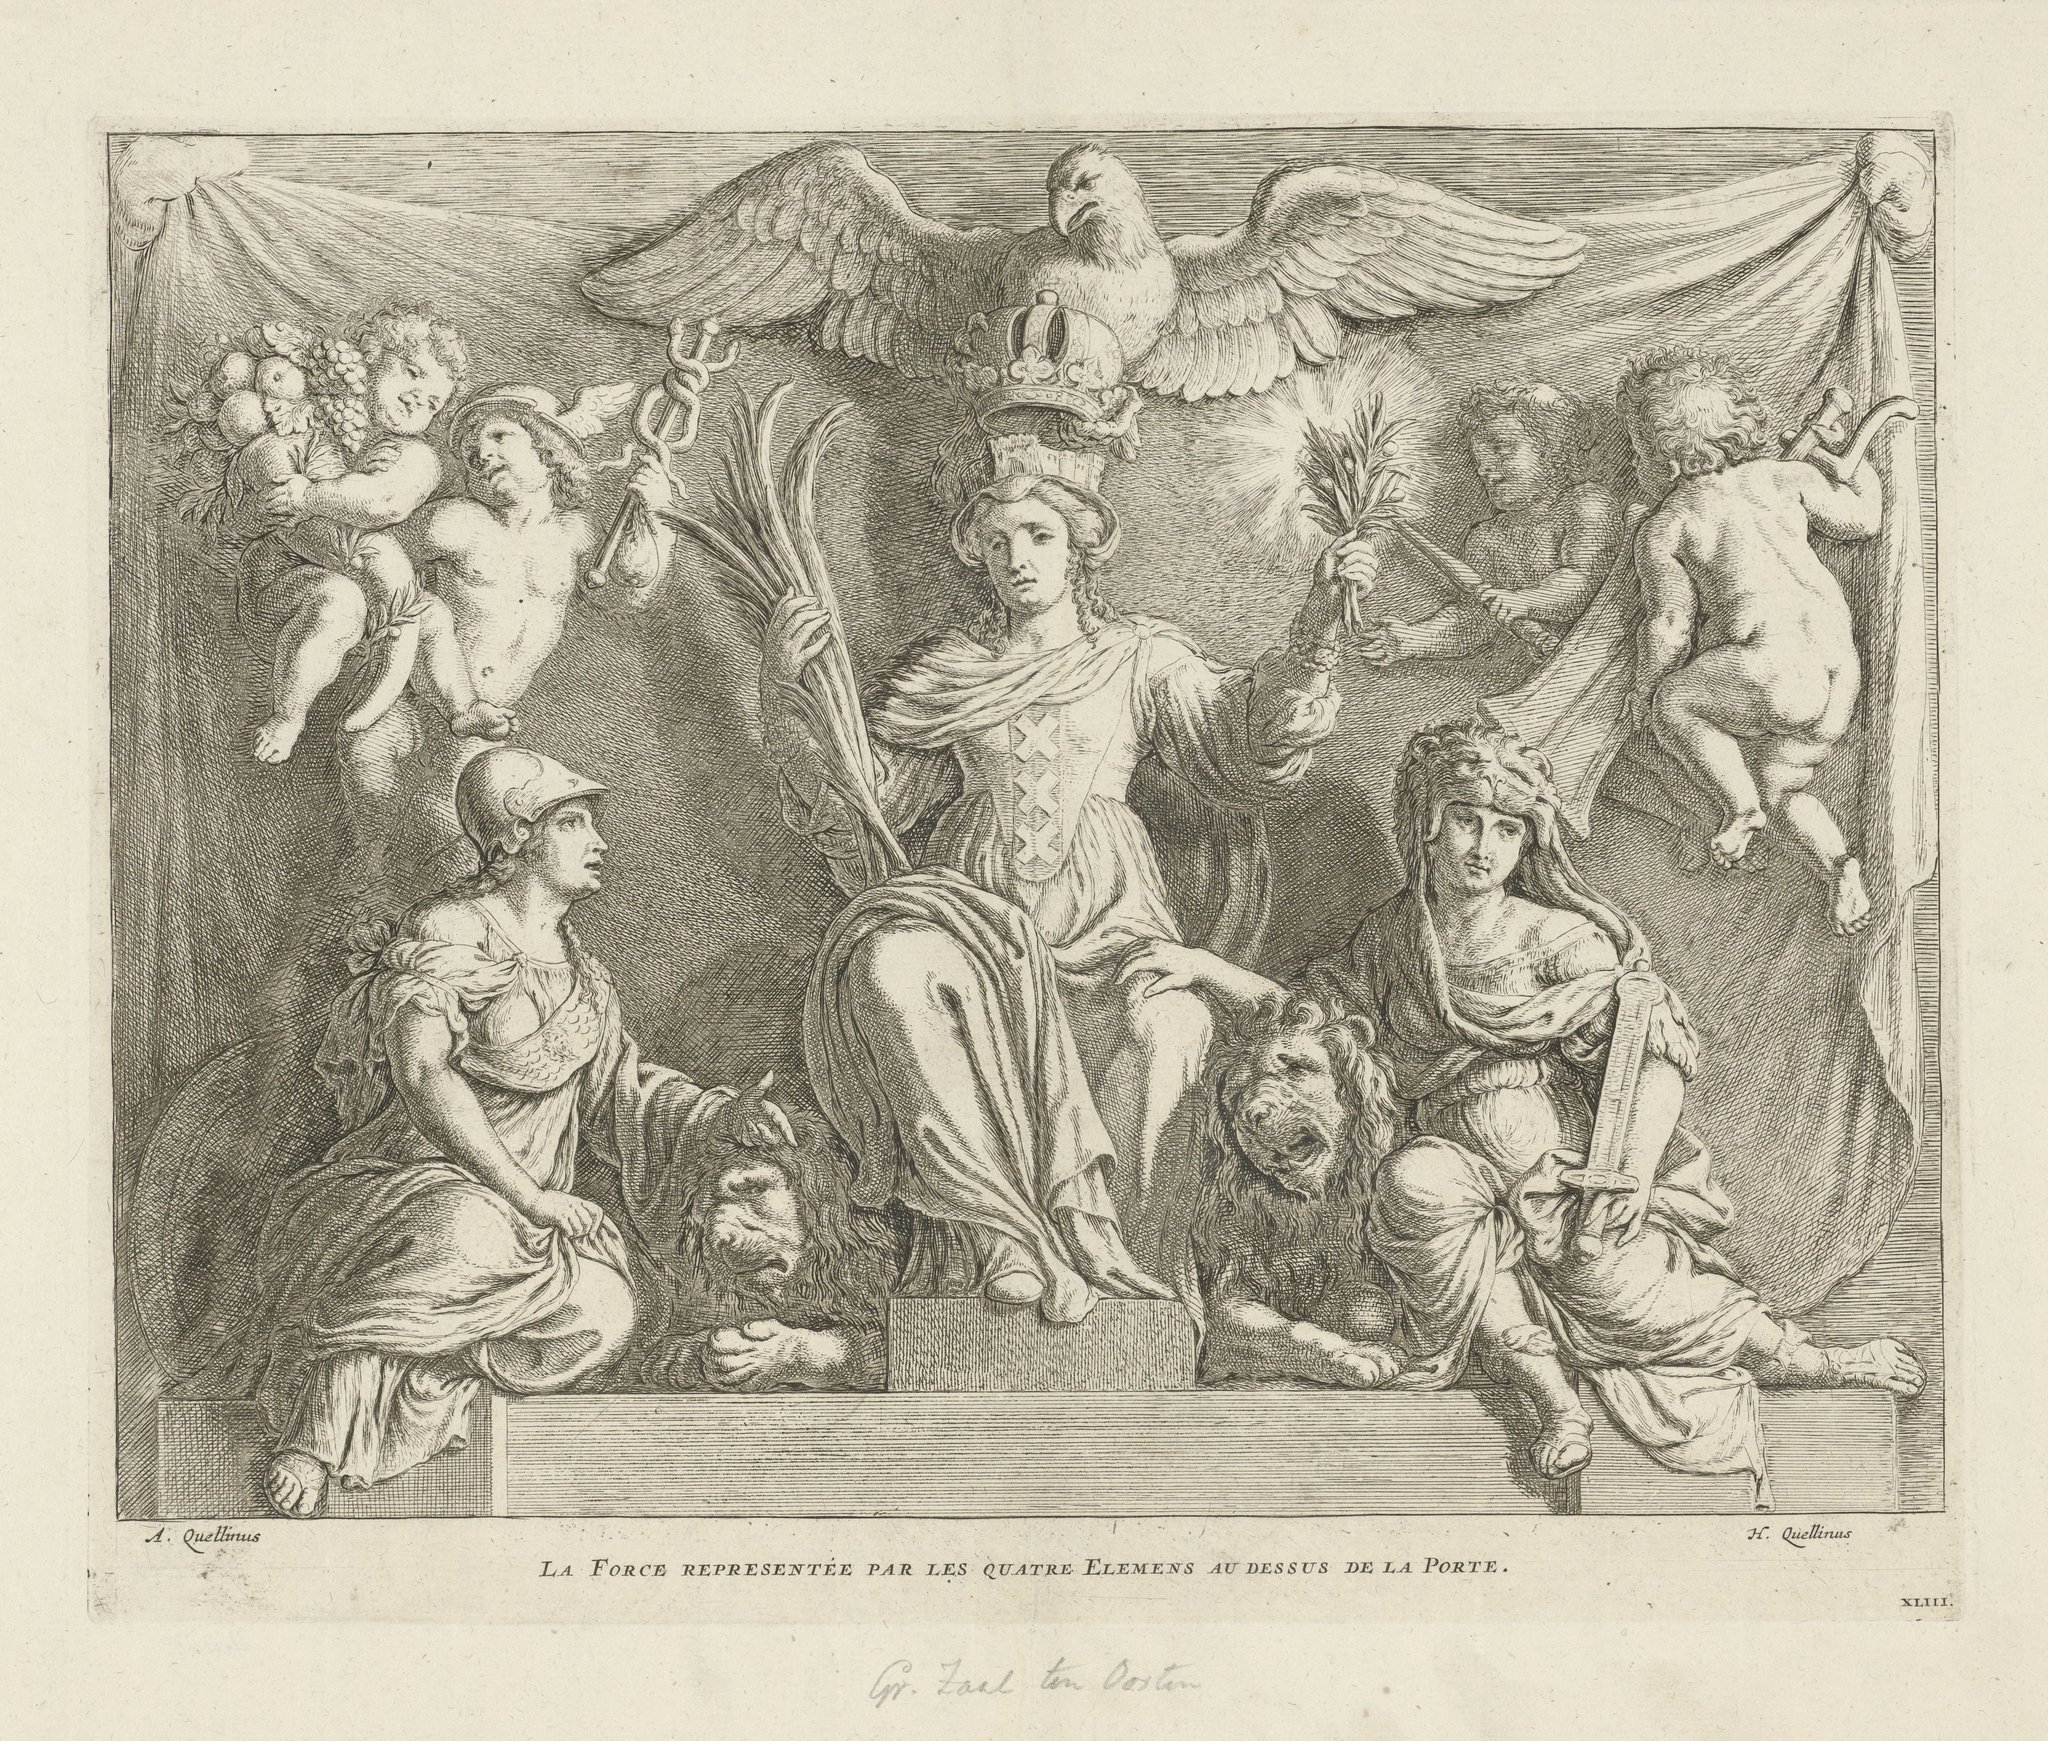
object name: print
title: Beeldengroep met allegorie op de Kracht van Amsterdam aan de oostzijde van de Burgerzaal in het Stadhuis op de Dam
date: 1665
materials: paper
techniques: engraving, etching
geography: amsterdam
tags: 'cornucopia', horn of plenty, earth (one of the four elements), predatory birds: eagle, symbols, allegories of peace, 'pax'; 'pace' (ripa), (story of) minerva (pallas, athena), attributes of hercules, wisdom; 'sapienza', 'sapienza humana', 'sapienza vera' (ripa), water (one of the four elements), fire (one of the four elements), air (one of the four elements), cities represented allegorically or symbolically, strength, power; 'fortezza', 'fortezza d'animo e di corpo', 'fortezza del corpo congiunta con la generosità dell'animo', 'fortezza & valore del corpo congiunto con la prudenza & virtù del animo', 'forza' (ripa), caduceus (staff with two snakes, attribute of mercury), attributes of mercury, parts of ship's exterior: rudder, beasts of prey, predatory animals: lion, cupids: 'amores', 'amoretti', 'putti', amsterdam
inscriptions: collector's mark: Lugt 2228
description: Huidige staat van prent ook gebruikt in: Architecture peinture et sculpture de la Maison de Ville d'Amsterdam, representee en CIX. figures en taille-douce (…). Amsterdam: David Mortier, 1719. En in: Architecture peinture et sculpture de la Maison de Ville d'Amsterdam, representee en CIX. figures en taille-douce (…). Amsterdam: Gerard Valck, 1719. En in: Bouw schilder en beeldhouwkonst, van het Stadhuis te Amsteldam, vertoont in CIX figuuren (…). Amsterdam: Covens & Mortier & Covens Jr., s.a. (1774-1783). Eerdere staat van prent ook gebruikt in: Secunca pars Praecipuarum effigierum ac ornamentorum amplissime Curiae Amstelrodamensis maiori ex parte in cadido marmore effectorum per Artum Quellinium eiusdem Civitatis Statuarium / Het tweede deel Van de voornaemste Statuen ende Cieraten van 't konst-rijcke Stadt-huys van Amstelredam 'tmeeste in Marmer gemaeckt door Artus Quellinus Beelthouwer der voorseyde Stadt. Amsterdam: Frederik de Wit, 1668. En komt ook voor in later ingebonden exemplaren van: Secunca pars Praecipuarum effigierum ac ornamentorum amplissime Curiae Amstelrodamensis maiori ex parte in cadido marmore effectorum per Artum Quellinium eiusdem Civitatis Statuarium / Het tweede deel Van de voornaemste Statuen ende Cieraten van 't konst-rijcke Stadt-huys van Amstelredam 'tmeeste in Marmer gemaeckt door Artus Quellinus Beelthouwer der voorseyde Stadt. Amsterdam: Artus Quellinus (I), 1663.